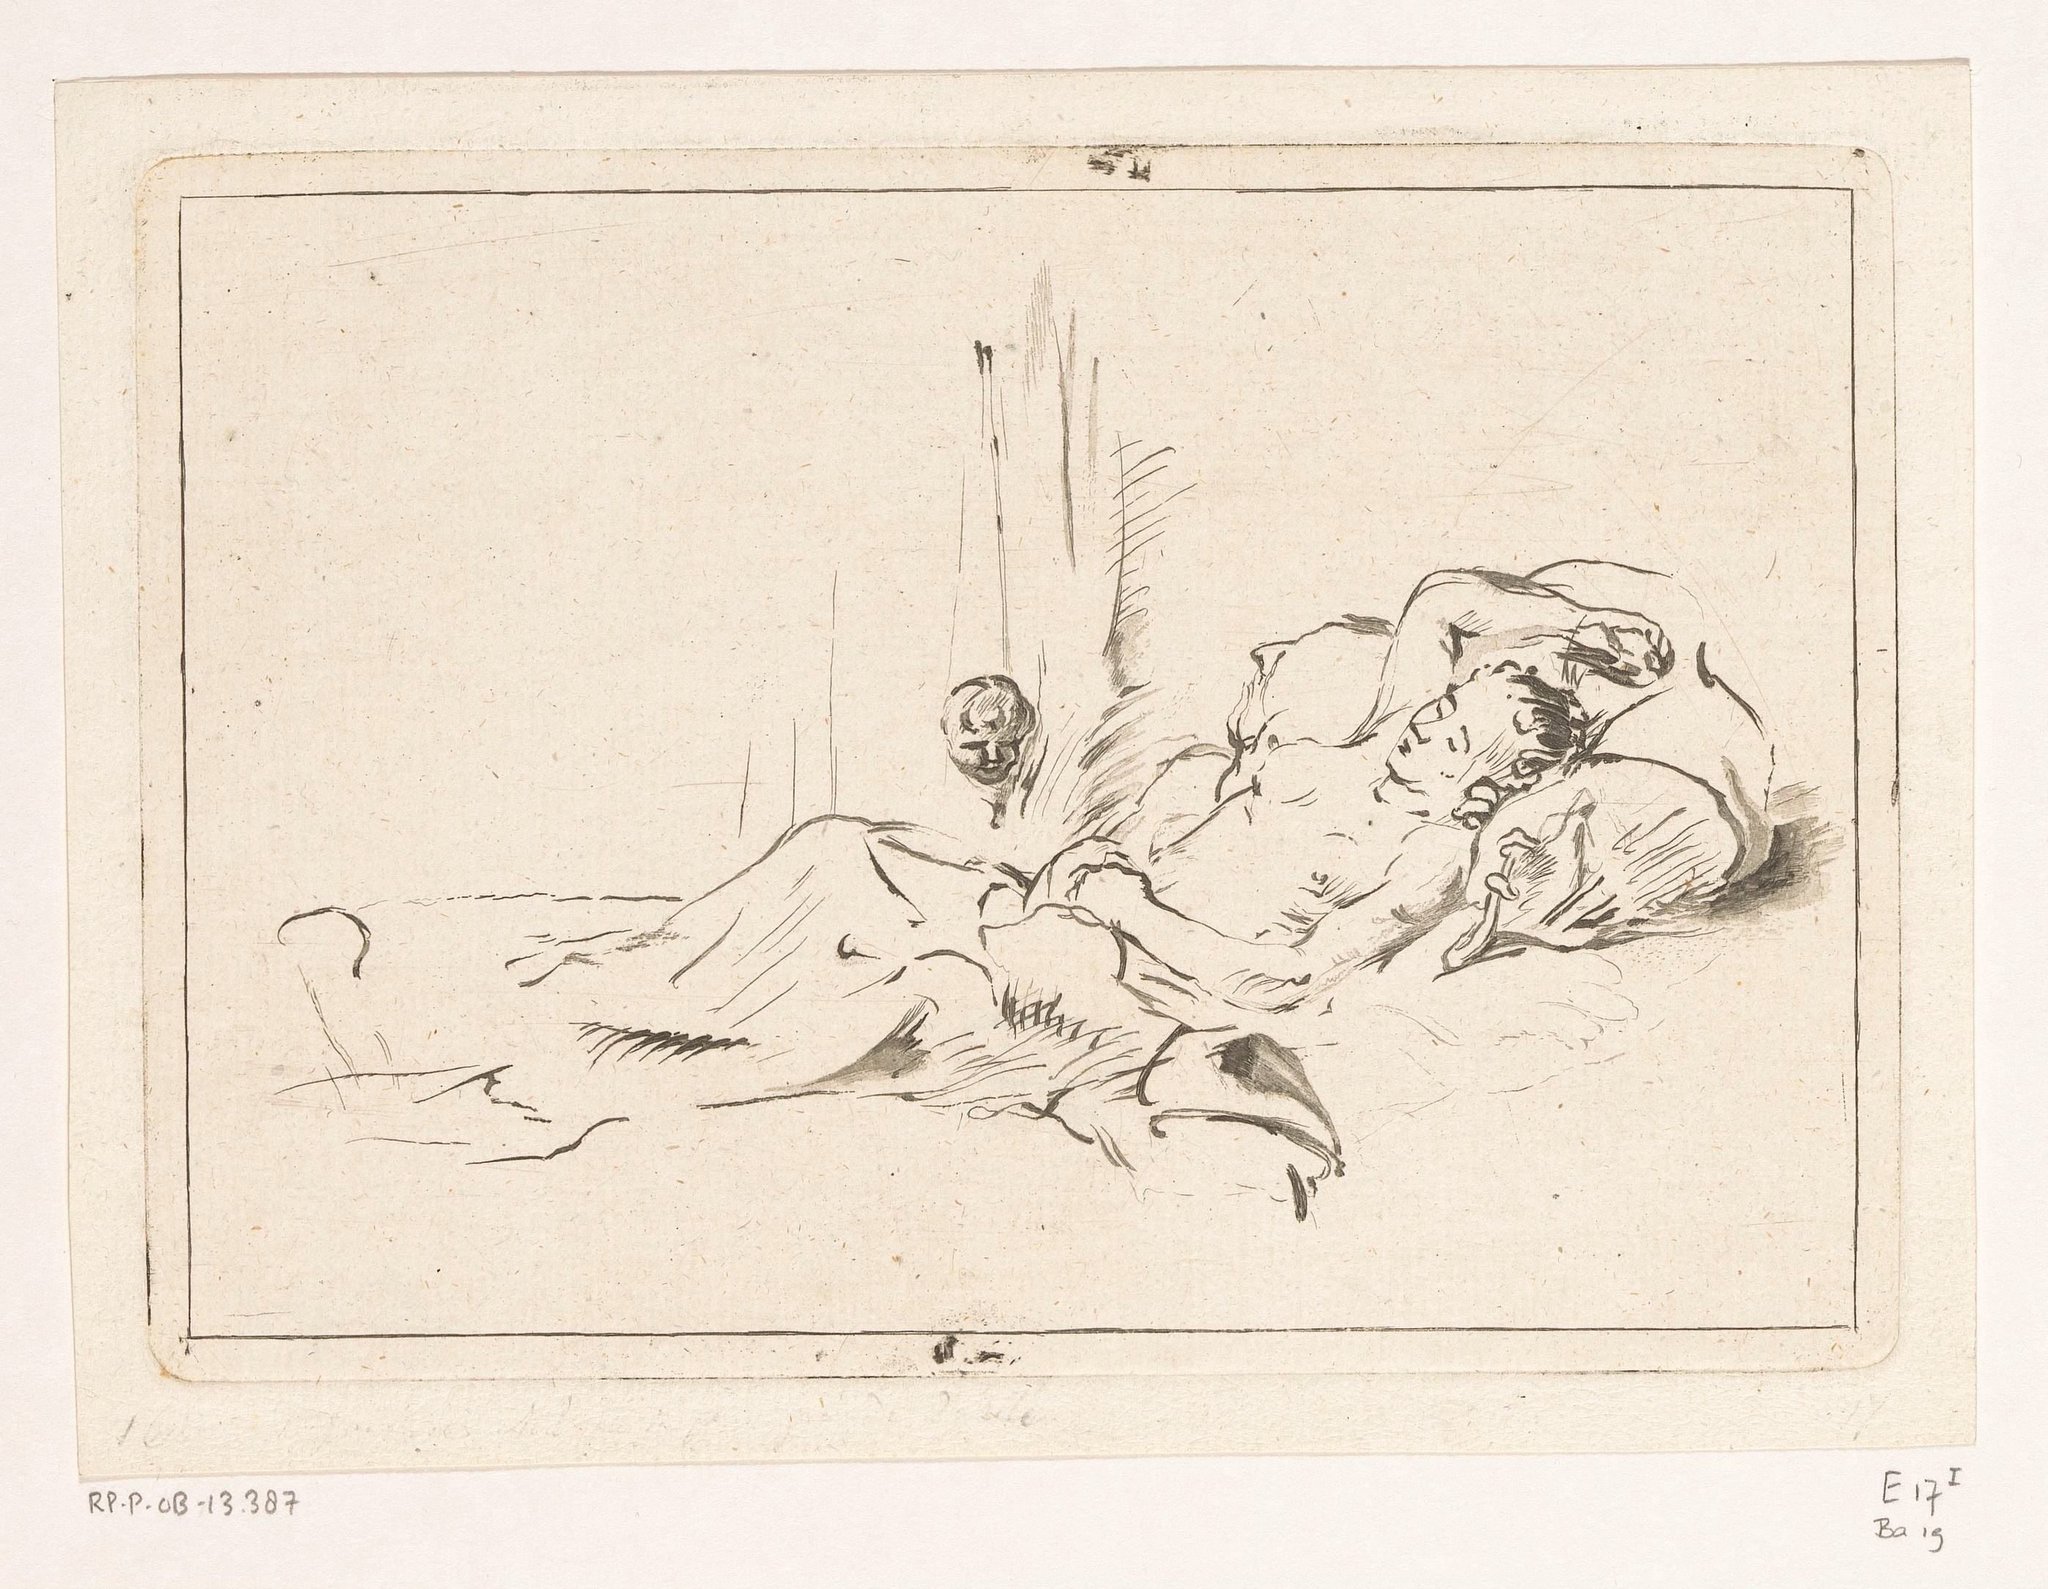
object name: print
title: Slapende vrouw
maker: daniel nikolaus chodowiecki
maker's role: draughtsman, print maker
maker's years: 1726-1801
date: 1759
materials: paper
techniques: aquatint, etching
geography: berlin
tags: sleeping; unconsciousness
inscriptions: collector's mark: Lugt 2228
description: De bankier en kunstverzamelaar Stieglitz gaf Chodowiecki opdracht om twee tekeningen uit zijn collectie in prent te brengen, waarvan dit er een is. Het voorbeeld van Rembrandt is tot op heden niet terug gevonden en is mogelijk verloren gegaan.